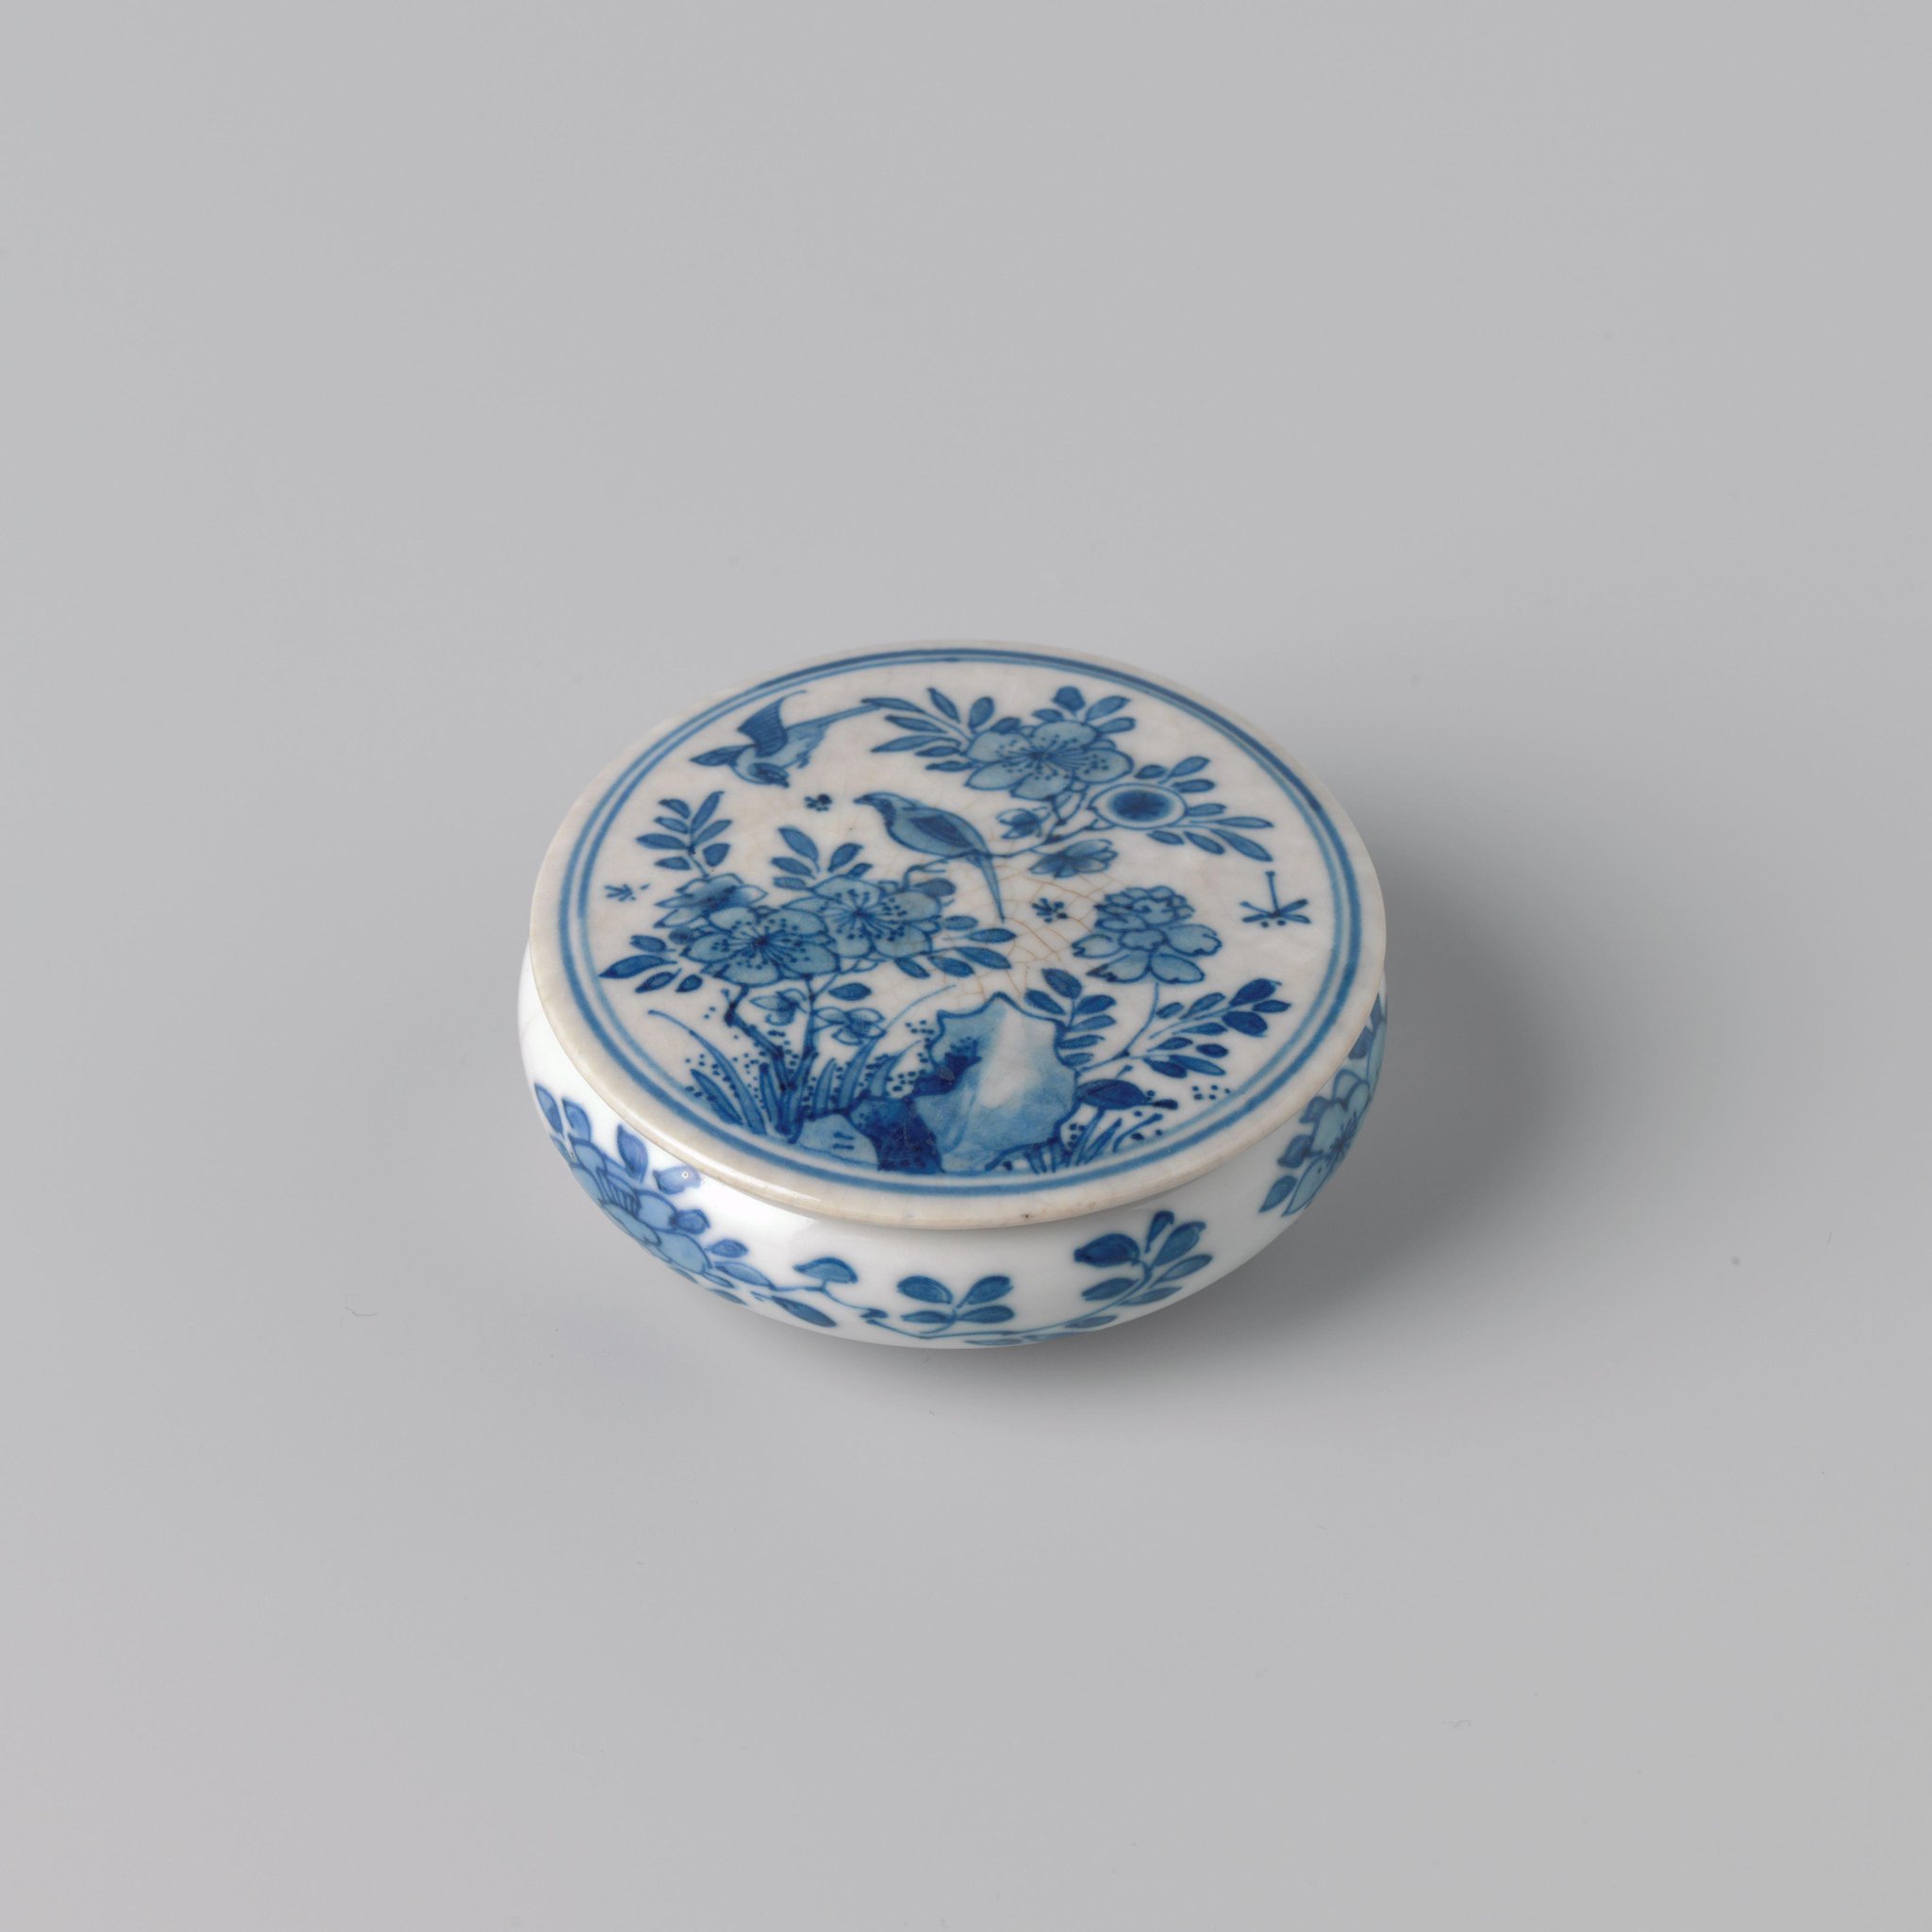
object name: box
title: Round box with flower sprays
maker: Anonymous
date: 1720-1740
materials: cobalt, glaze, paint, porcelain, soft paste porcelain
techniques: firing, turning, vitrification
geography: china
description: Ronde doos op voetring, met een bijna platte deksel. Gemaakt van 'soft-paste' porselein. Gedecoreerd in onderglazuur blauw met op het lichaam bloemranken. Op de deksel bloeiende planten en een vogel naast een rots. De binnenkant van de deksel is beschilderd met een erotische scène van twee naakte geliefden op een bed. De binnenzijde van de doos vertoont sporen van een rood pigment.